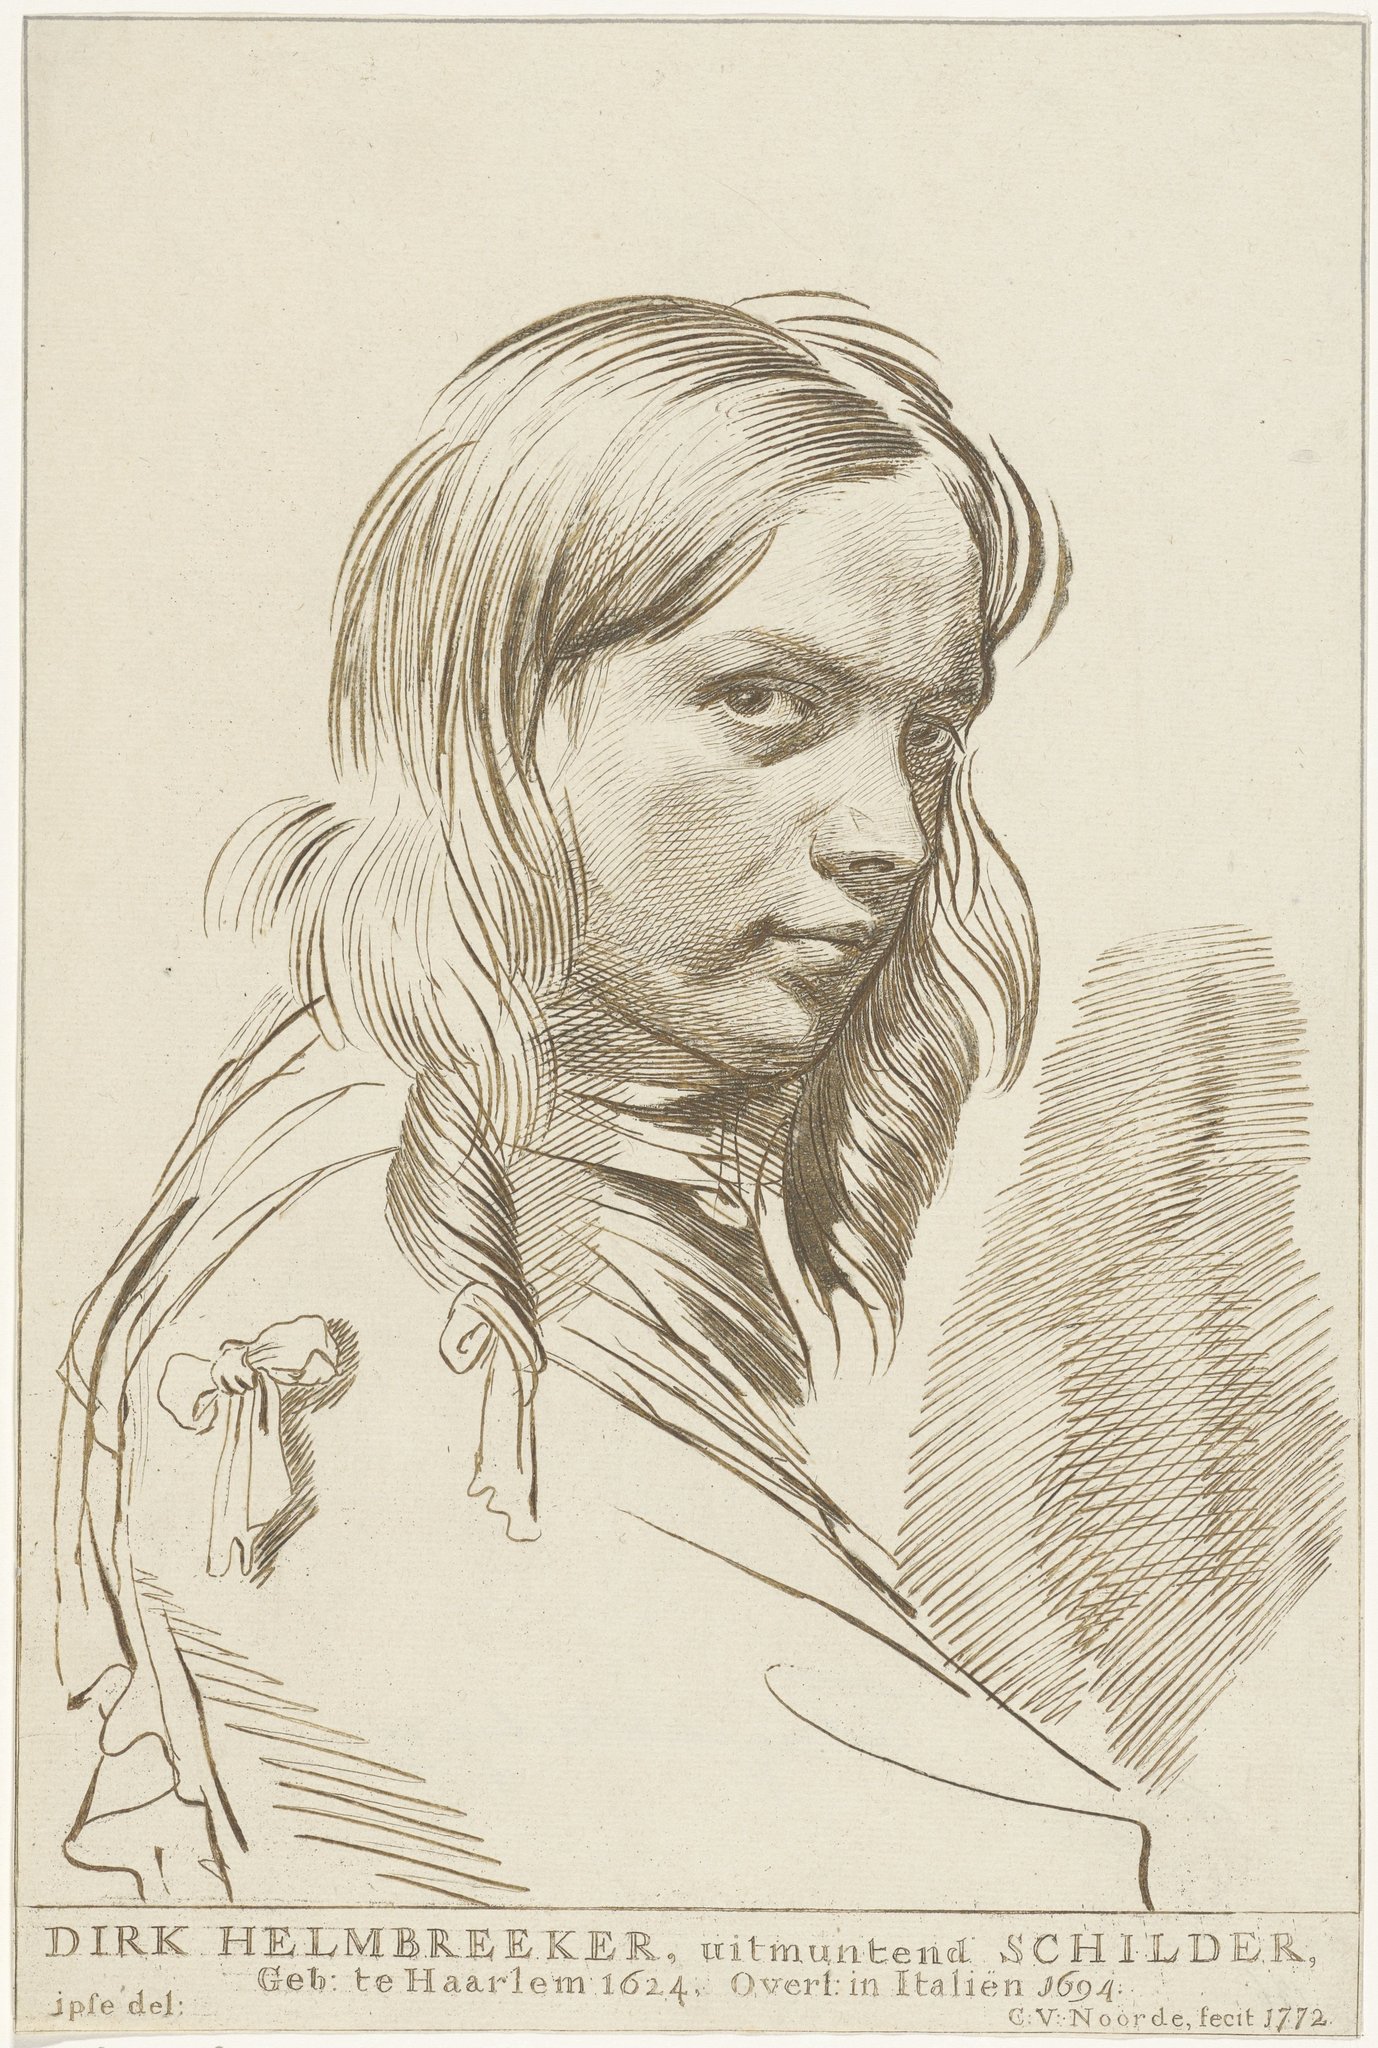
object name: print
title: Portret van Dirck Helmbreeker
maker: cornelis van noorde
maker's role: draughtsman, print maker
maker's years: 1731-1795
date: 1772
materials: paper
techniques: printing, printmaking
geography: haarlem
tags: haarlem, rome, painter, draughtsman, dirck helmbreeker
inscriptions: collector's mark: Lugt 240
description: Portret van de schilder Dirck Helmbreeker.